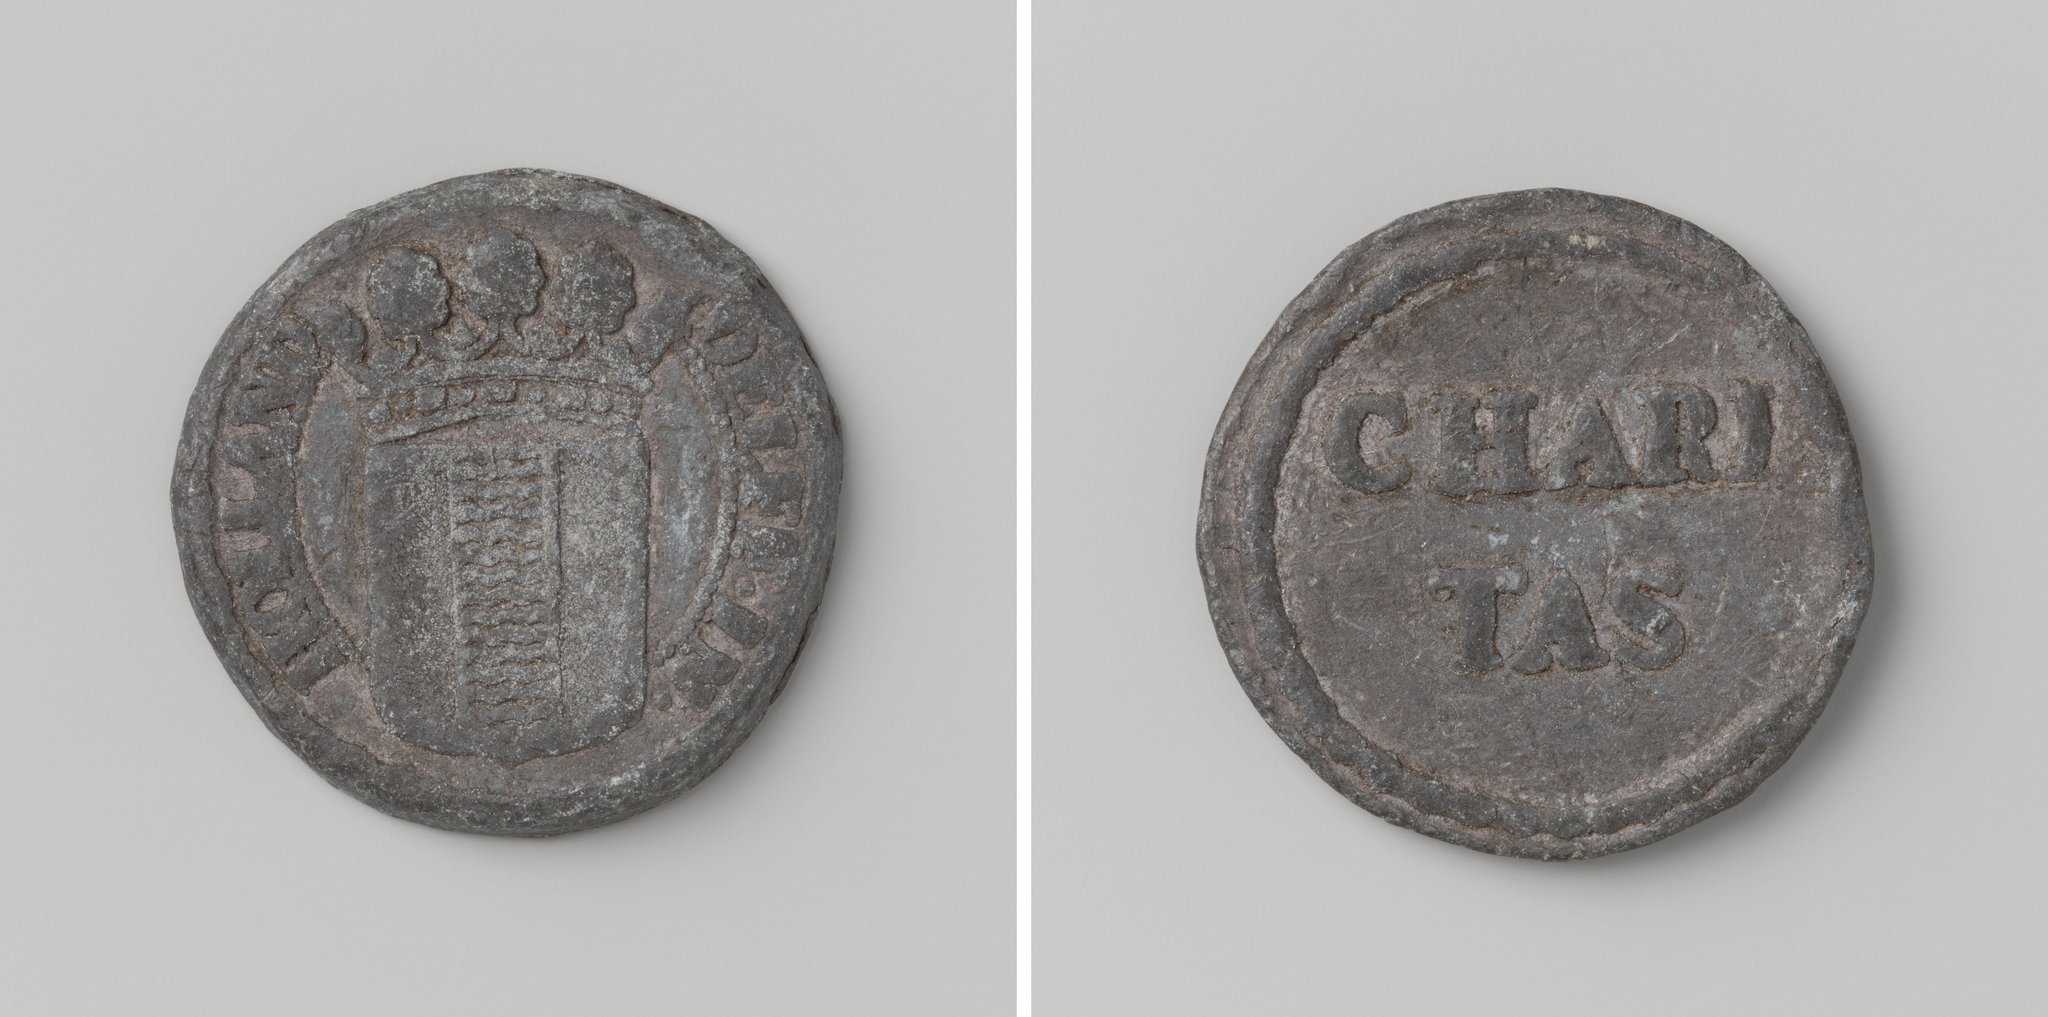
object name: armenloodje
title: Charitatenhuis te Delft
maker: Anonymous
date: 1600-1800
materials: lead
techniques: casting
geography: delft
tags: delft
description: Loden penning. Voorzijde: gekroond wapenschild binnen omschrift. Keerzijde: opschrift